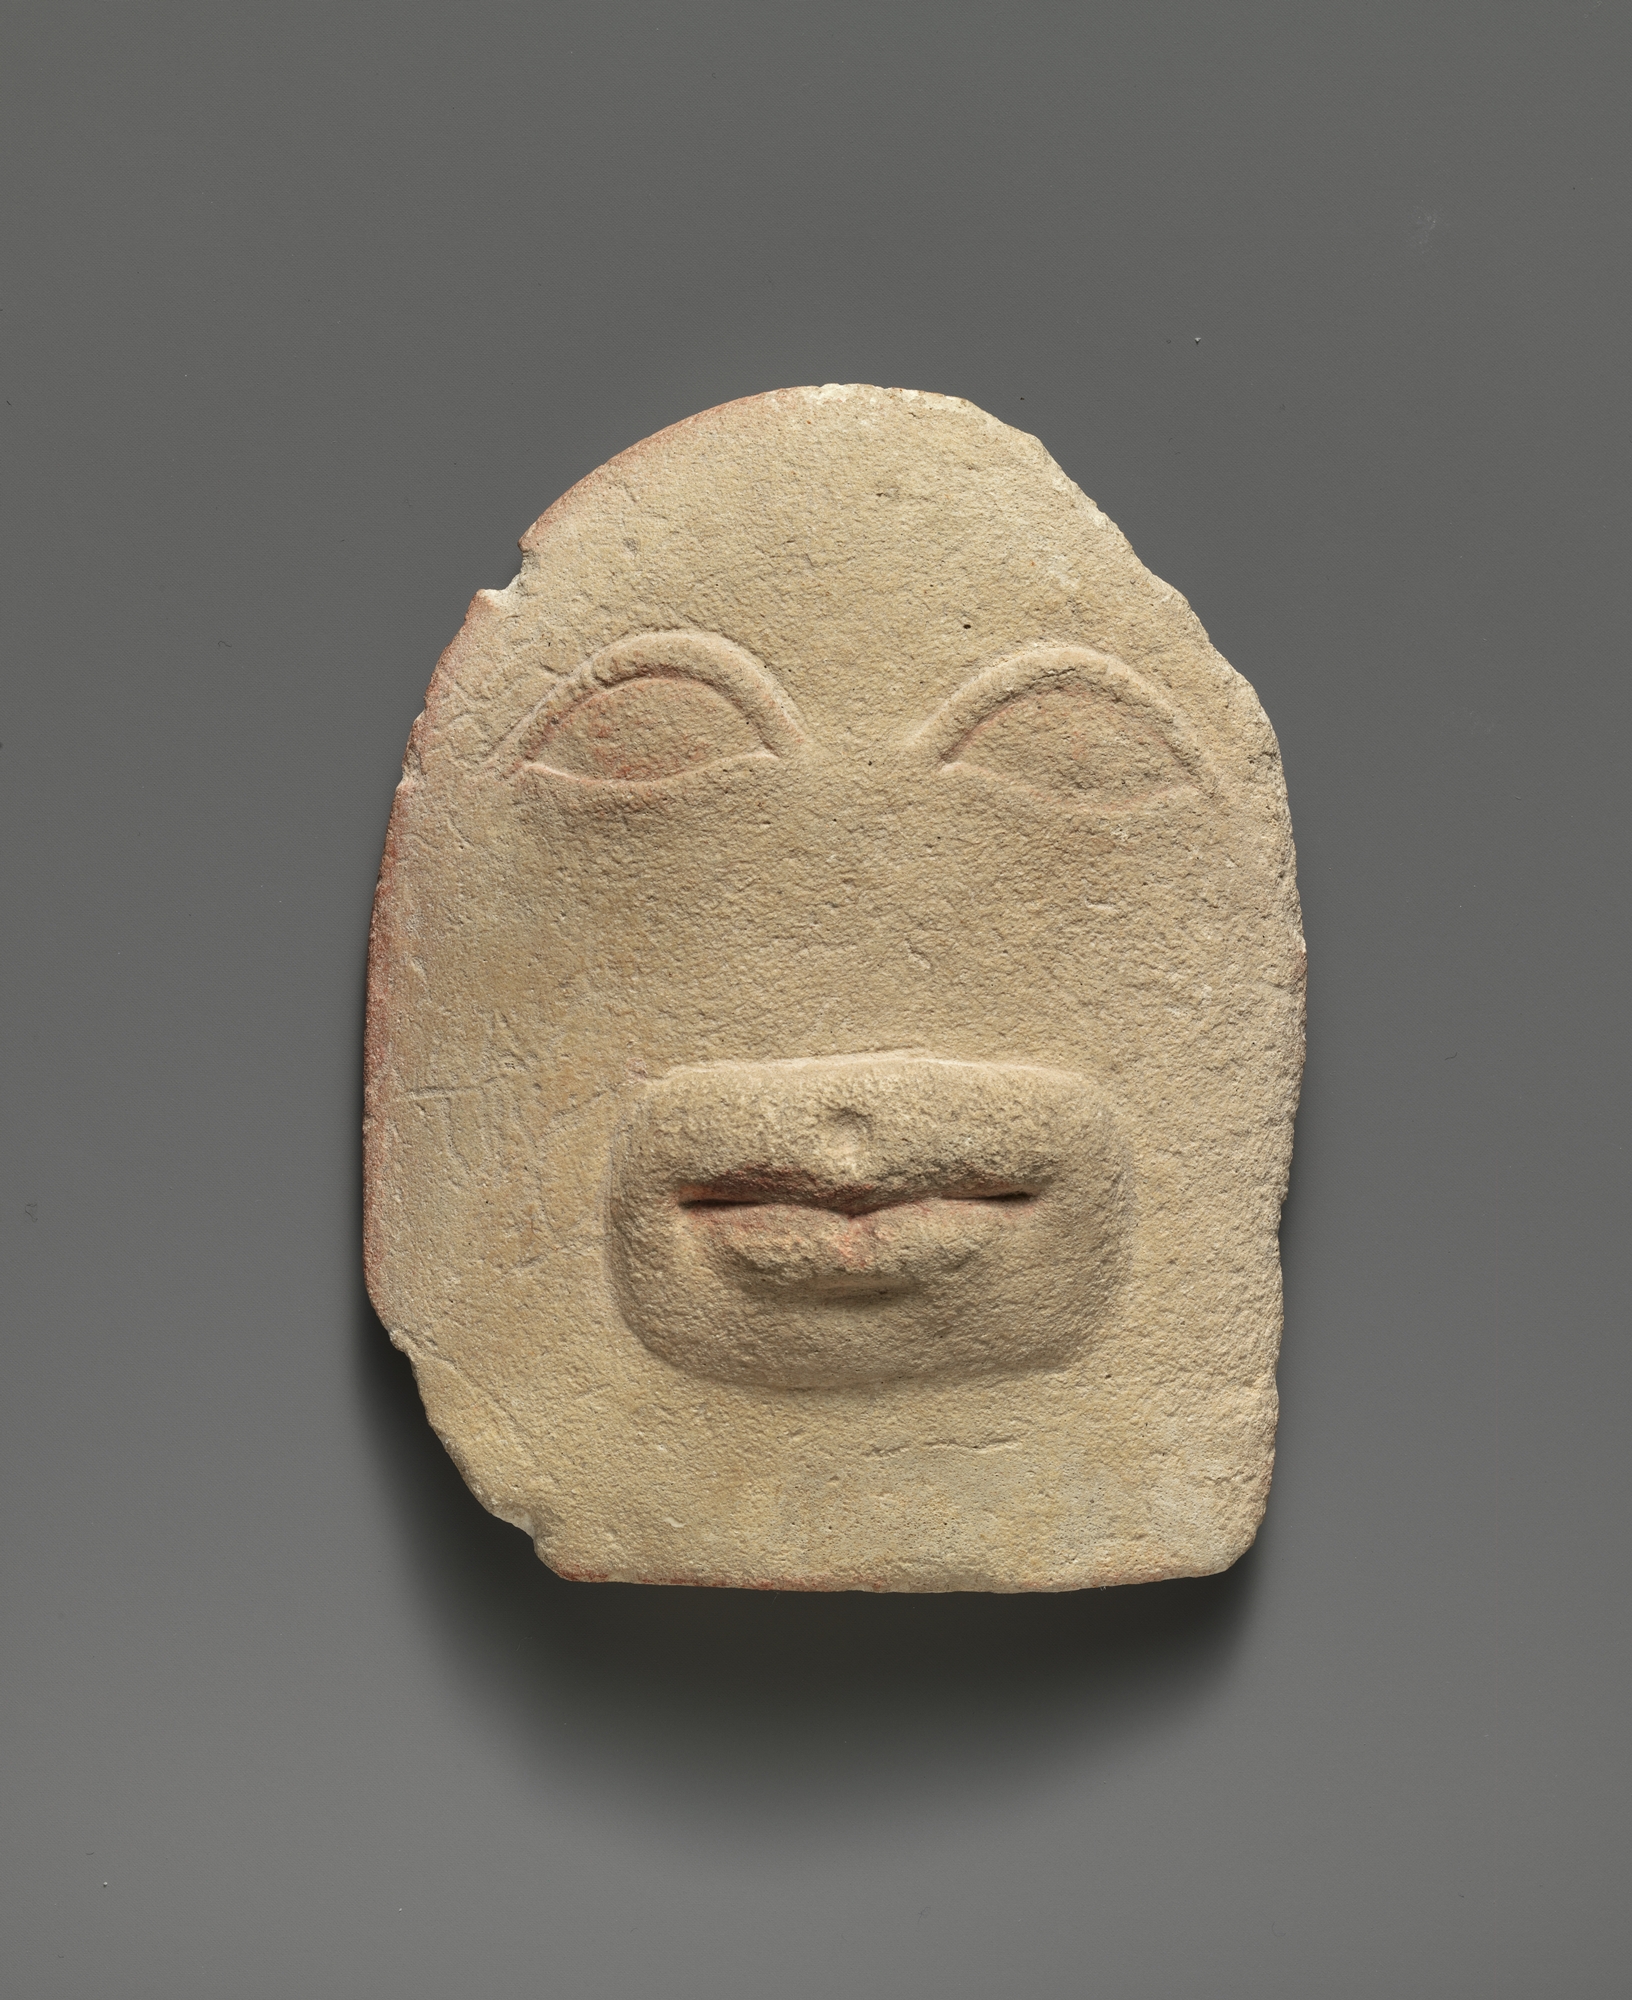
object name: votive relief of eye and a mouth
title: Limestone votive relief of eyes and a mouth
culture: cypriot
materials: limestone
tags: eyes,mouths